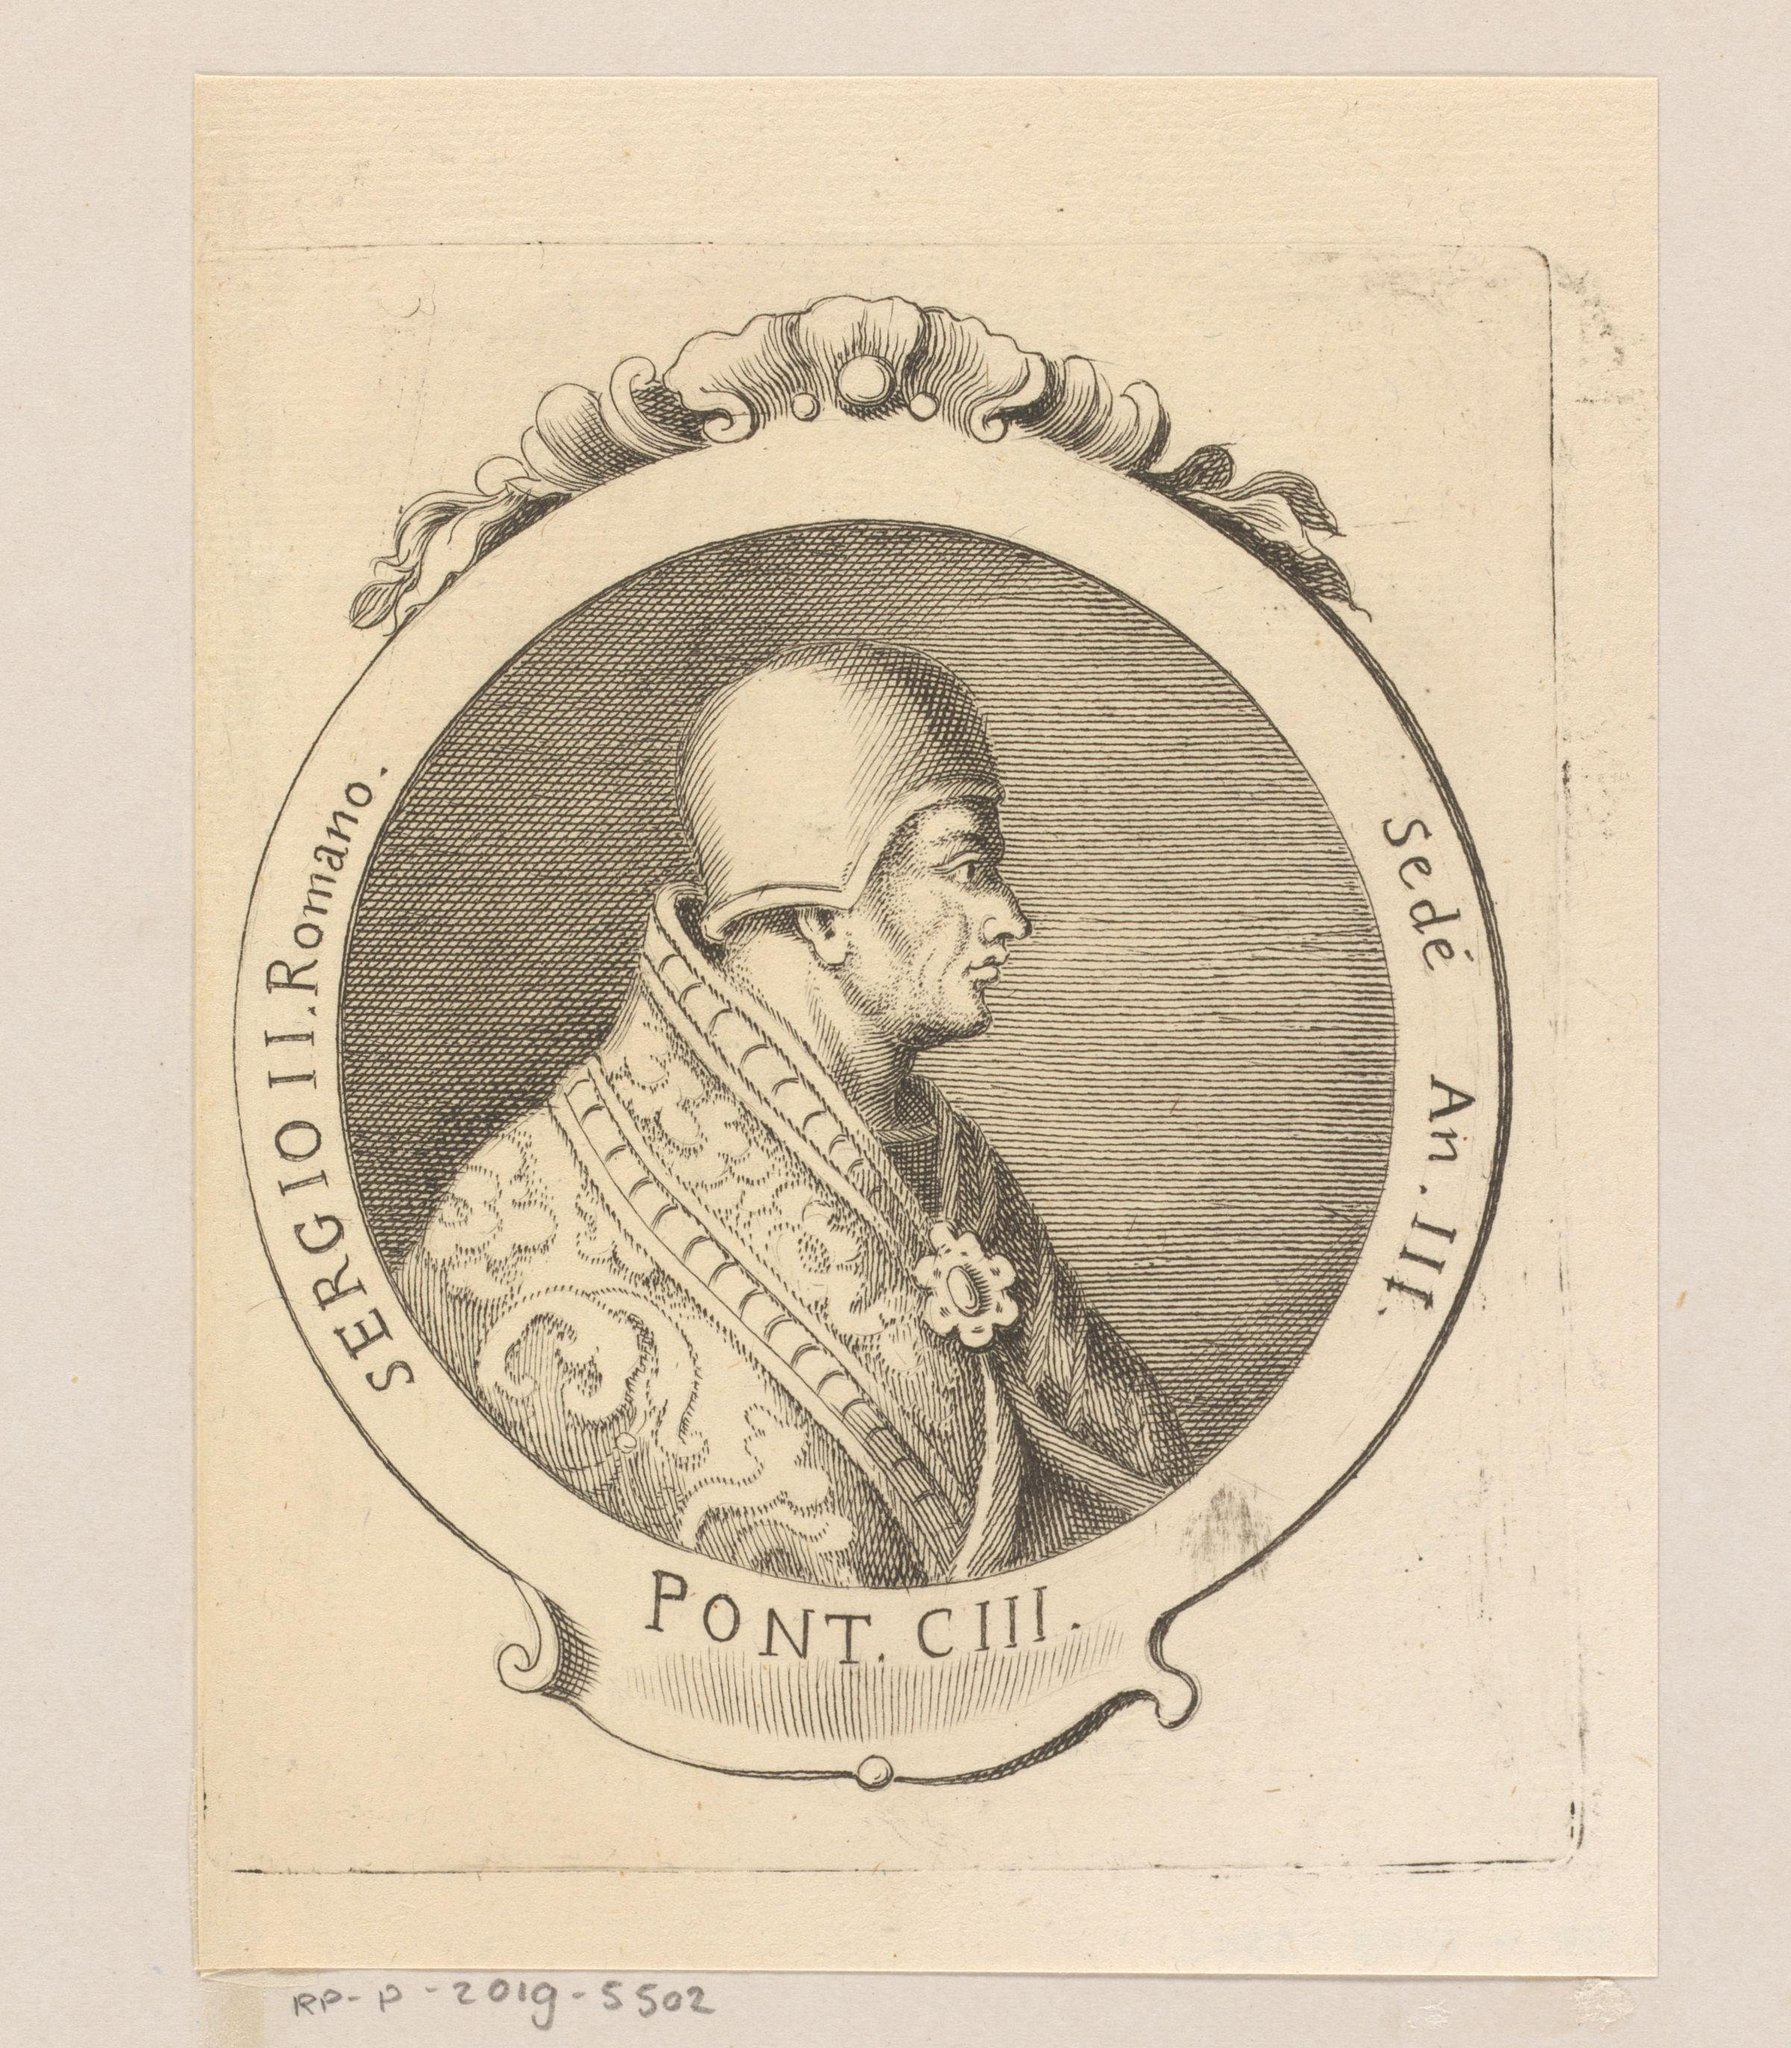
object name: print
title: Portret van paus Sergius II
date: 1775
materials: paper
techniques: etching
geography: venice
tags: rome, historical persons, pope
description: Prent uit: Effigies Romanorum pontificum a S. Petro ad Pium VI. feliciter regnantem (...). 2 dln. Venetië en Bassano del Grappa: Giuseppe Remondini, 1775.